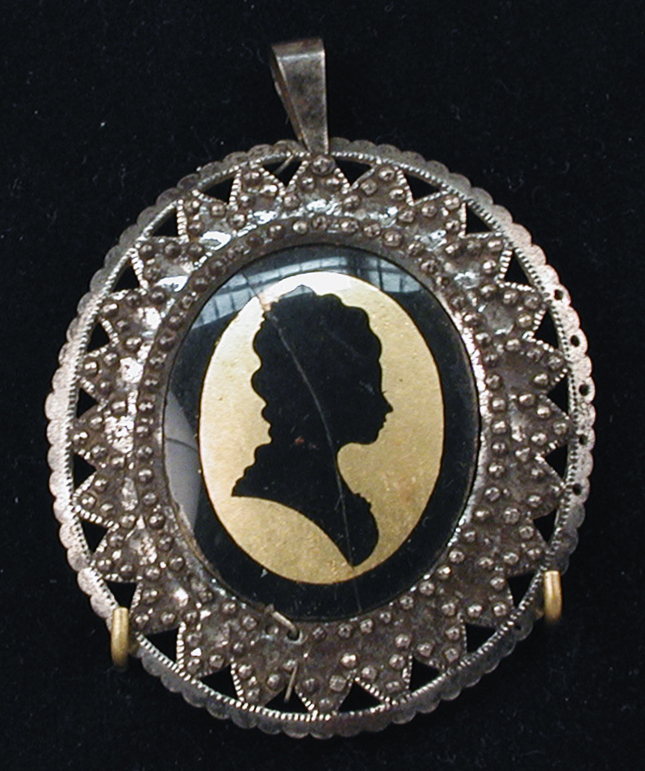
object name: pendant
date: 1801-1900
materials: glass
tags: profiles,women